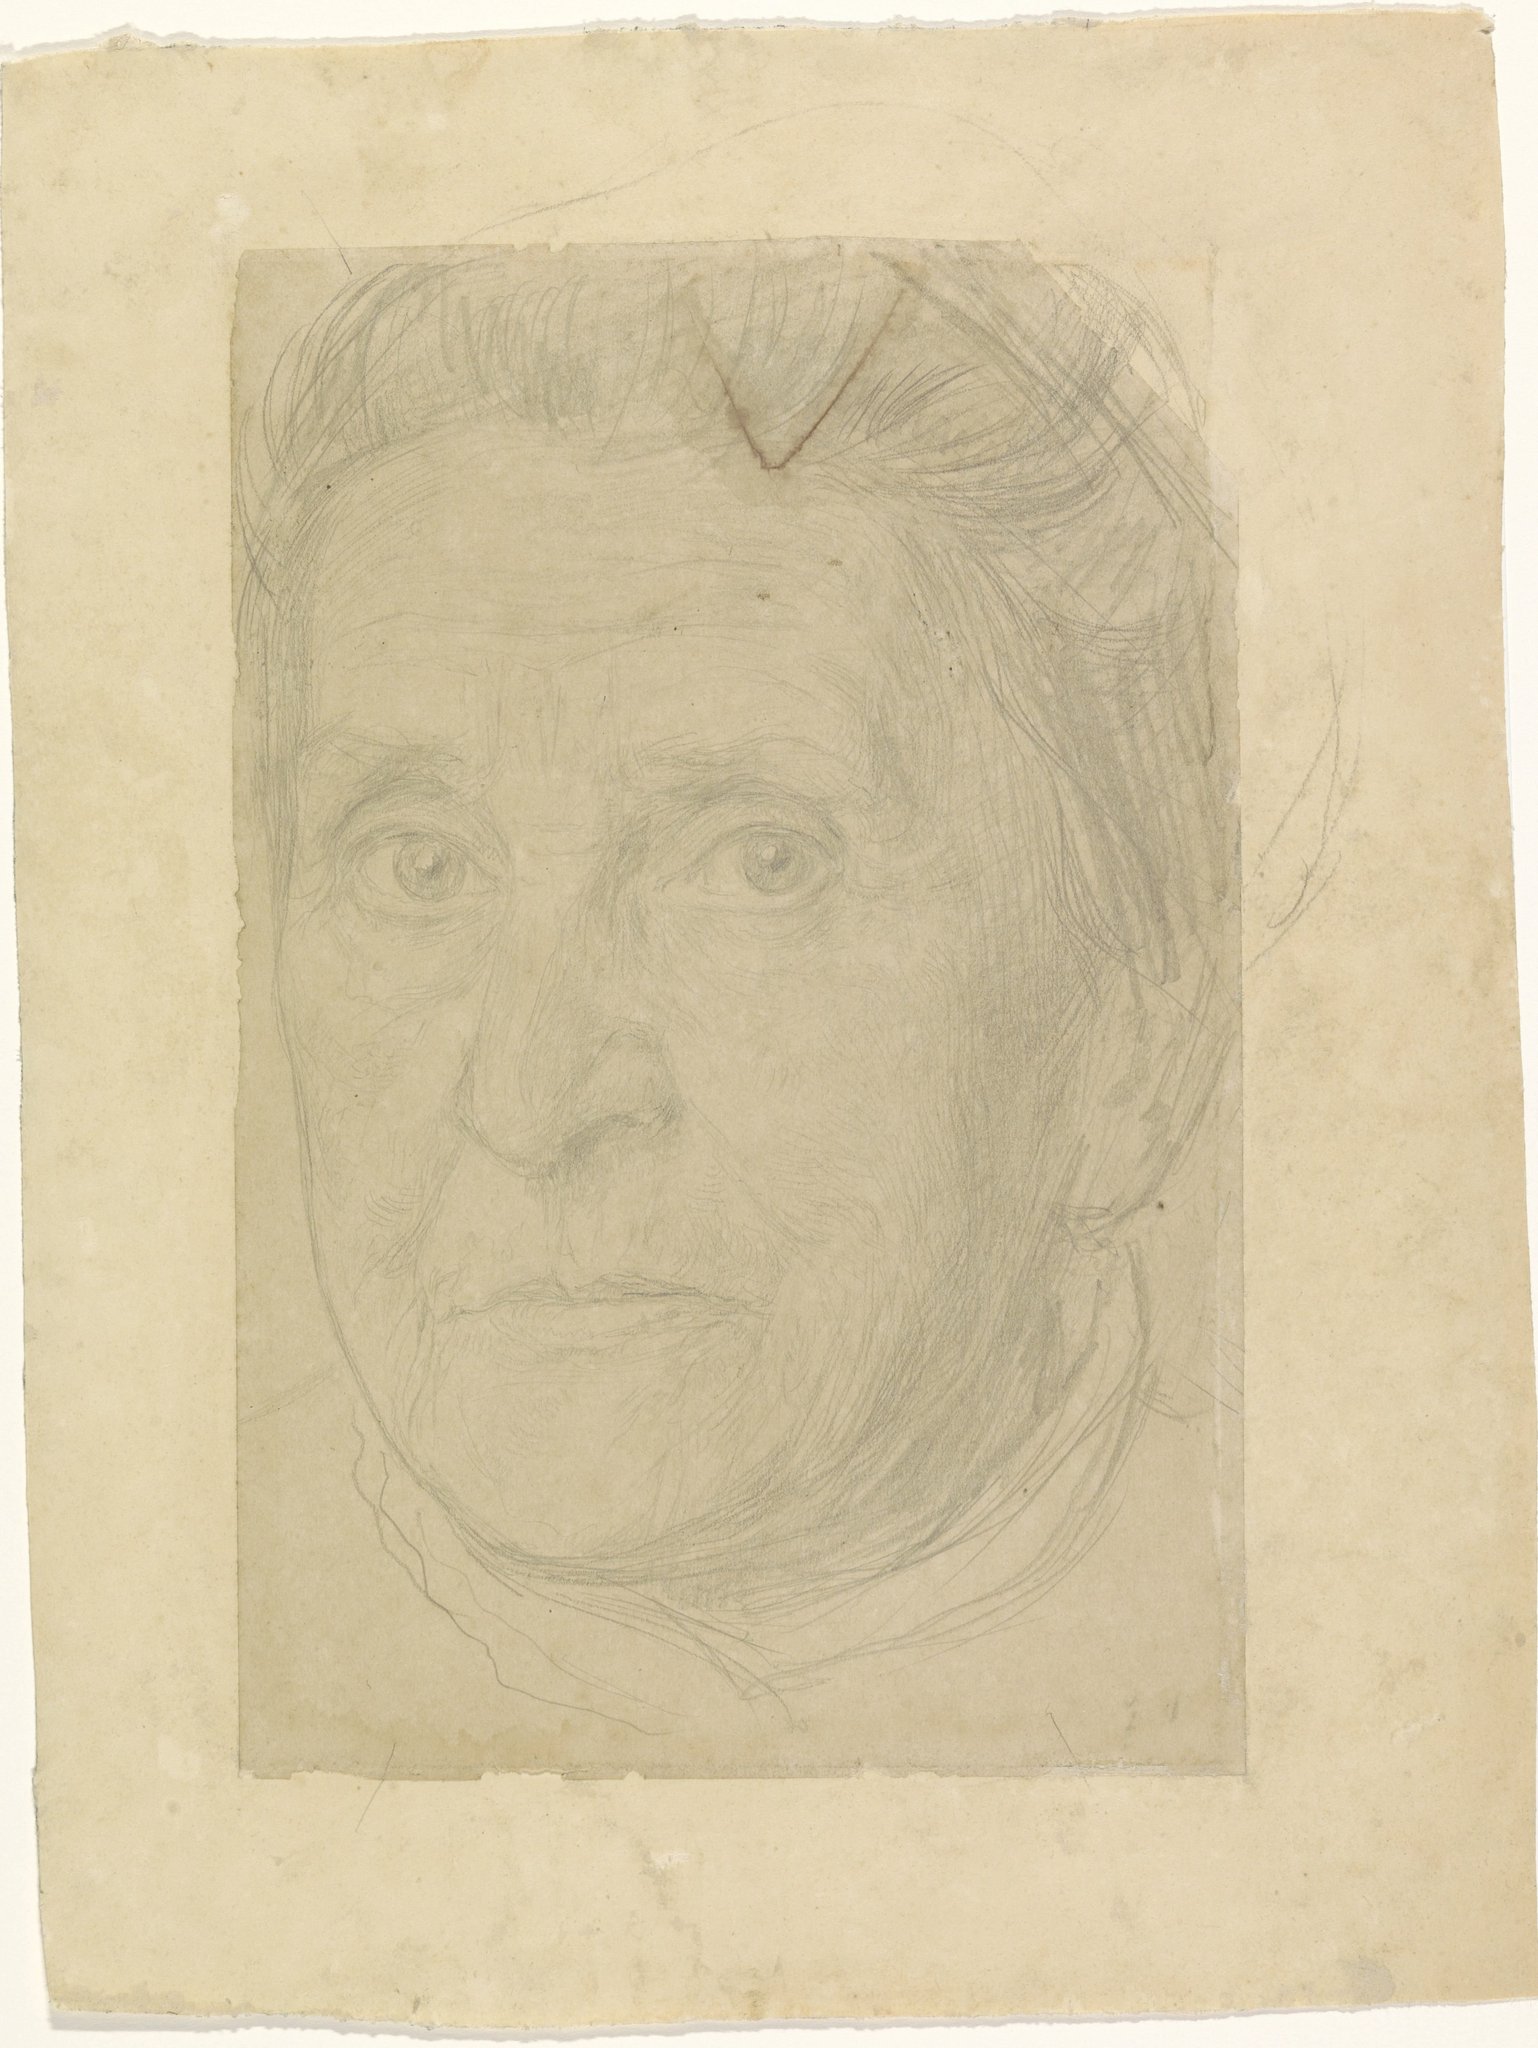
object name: drawing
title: Portret van mevrouw M.J. van Rennès-de Jongh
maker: jan veth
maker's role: designer, draughtsman, painter, print maker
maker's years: 1864-1925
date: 1874-1925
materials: paper, pencil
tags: historical persons - bb - woman